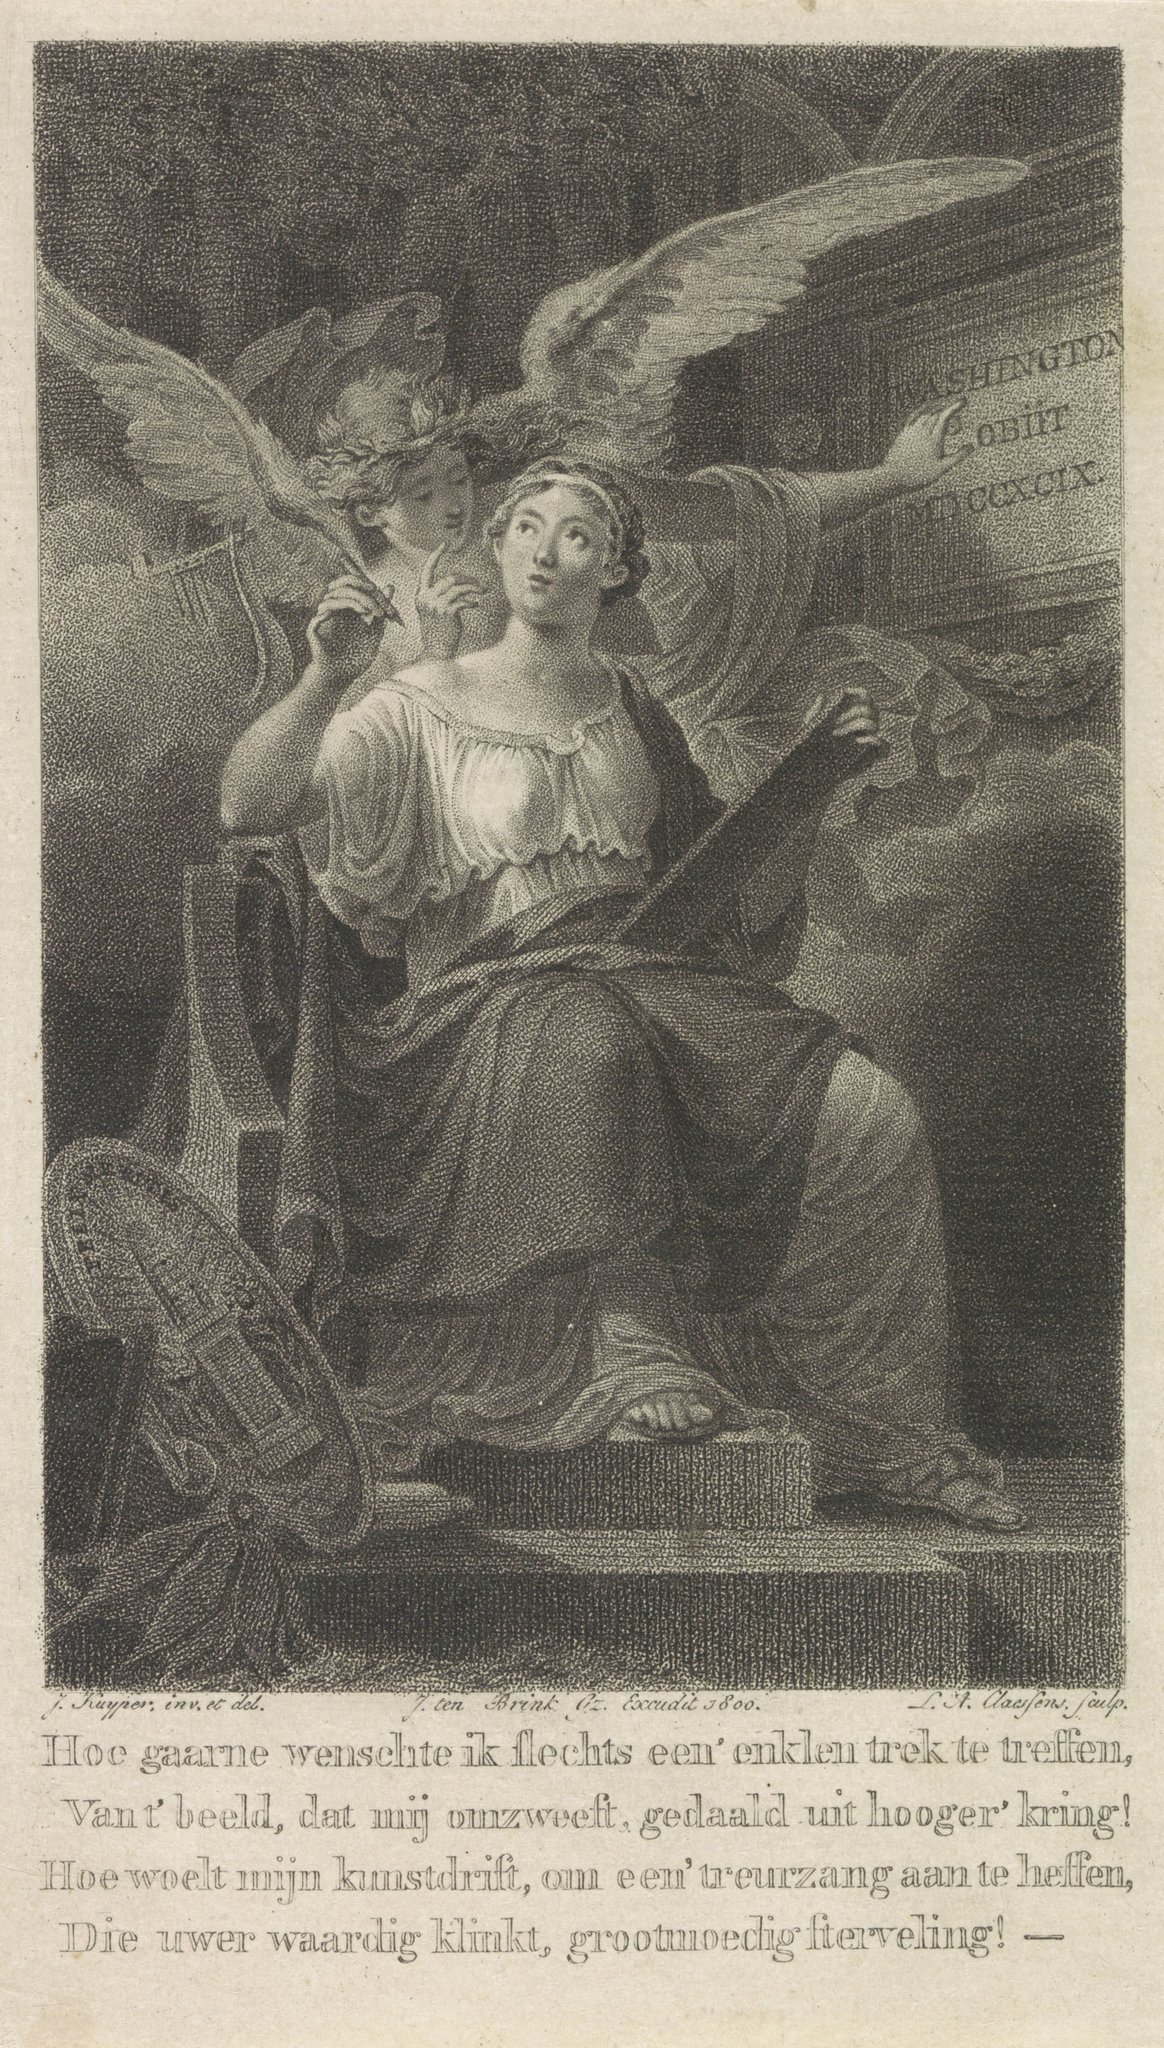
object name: print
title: Allegorie op Washingtons dood, 1799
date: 1800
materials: paper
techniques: stippled etching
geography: netherlands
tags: 'historia'; 'historia' (ripa), grave-building, monumental tomb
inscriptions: collector's mark: Lugt 2228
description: De geschiedenis voorgesteld door eene jeugdige vrouw wordt door een genius gewezen op een monument, waarop men leest Washington obiit MDCCXCIX. In de marge een vierregelig vers: "Hoe gaarne wenschte ik slechts" enz.